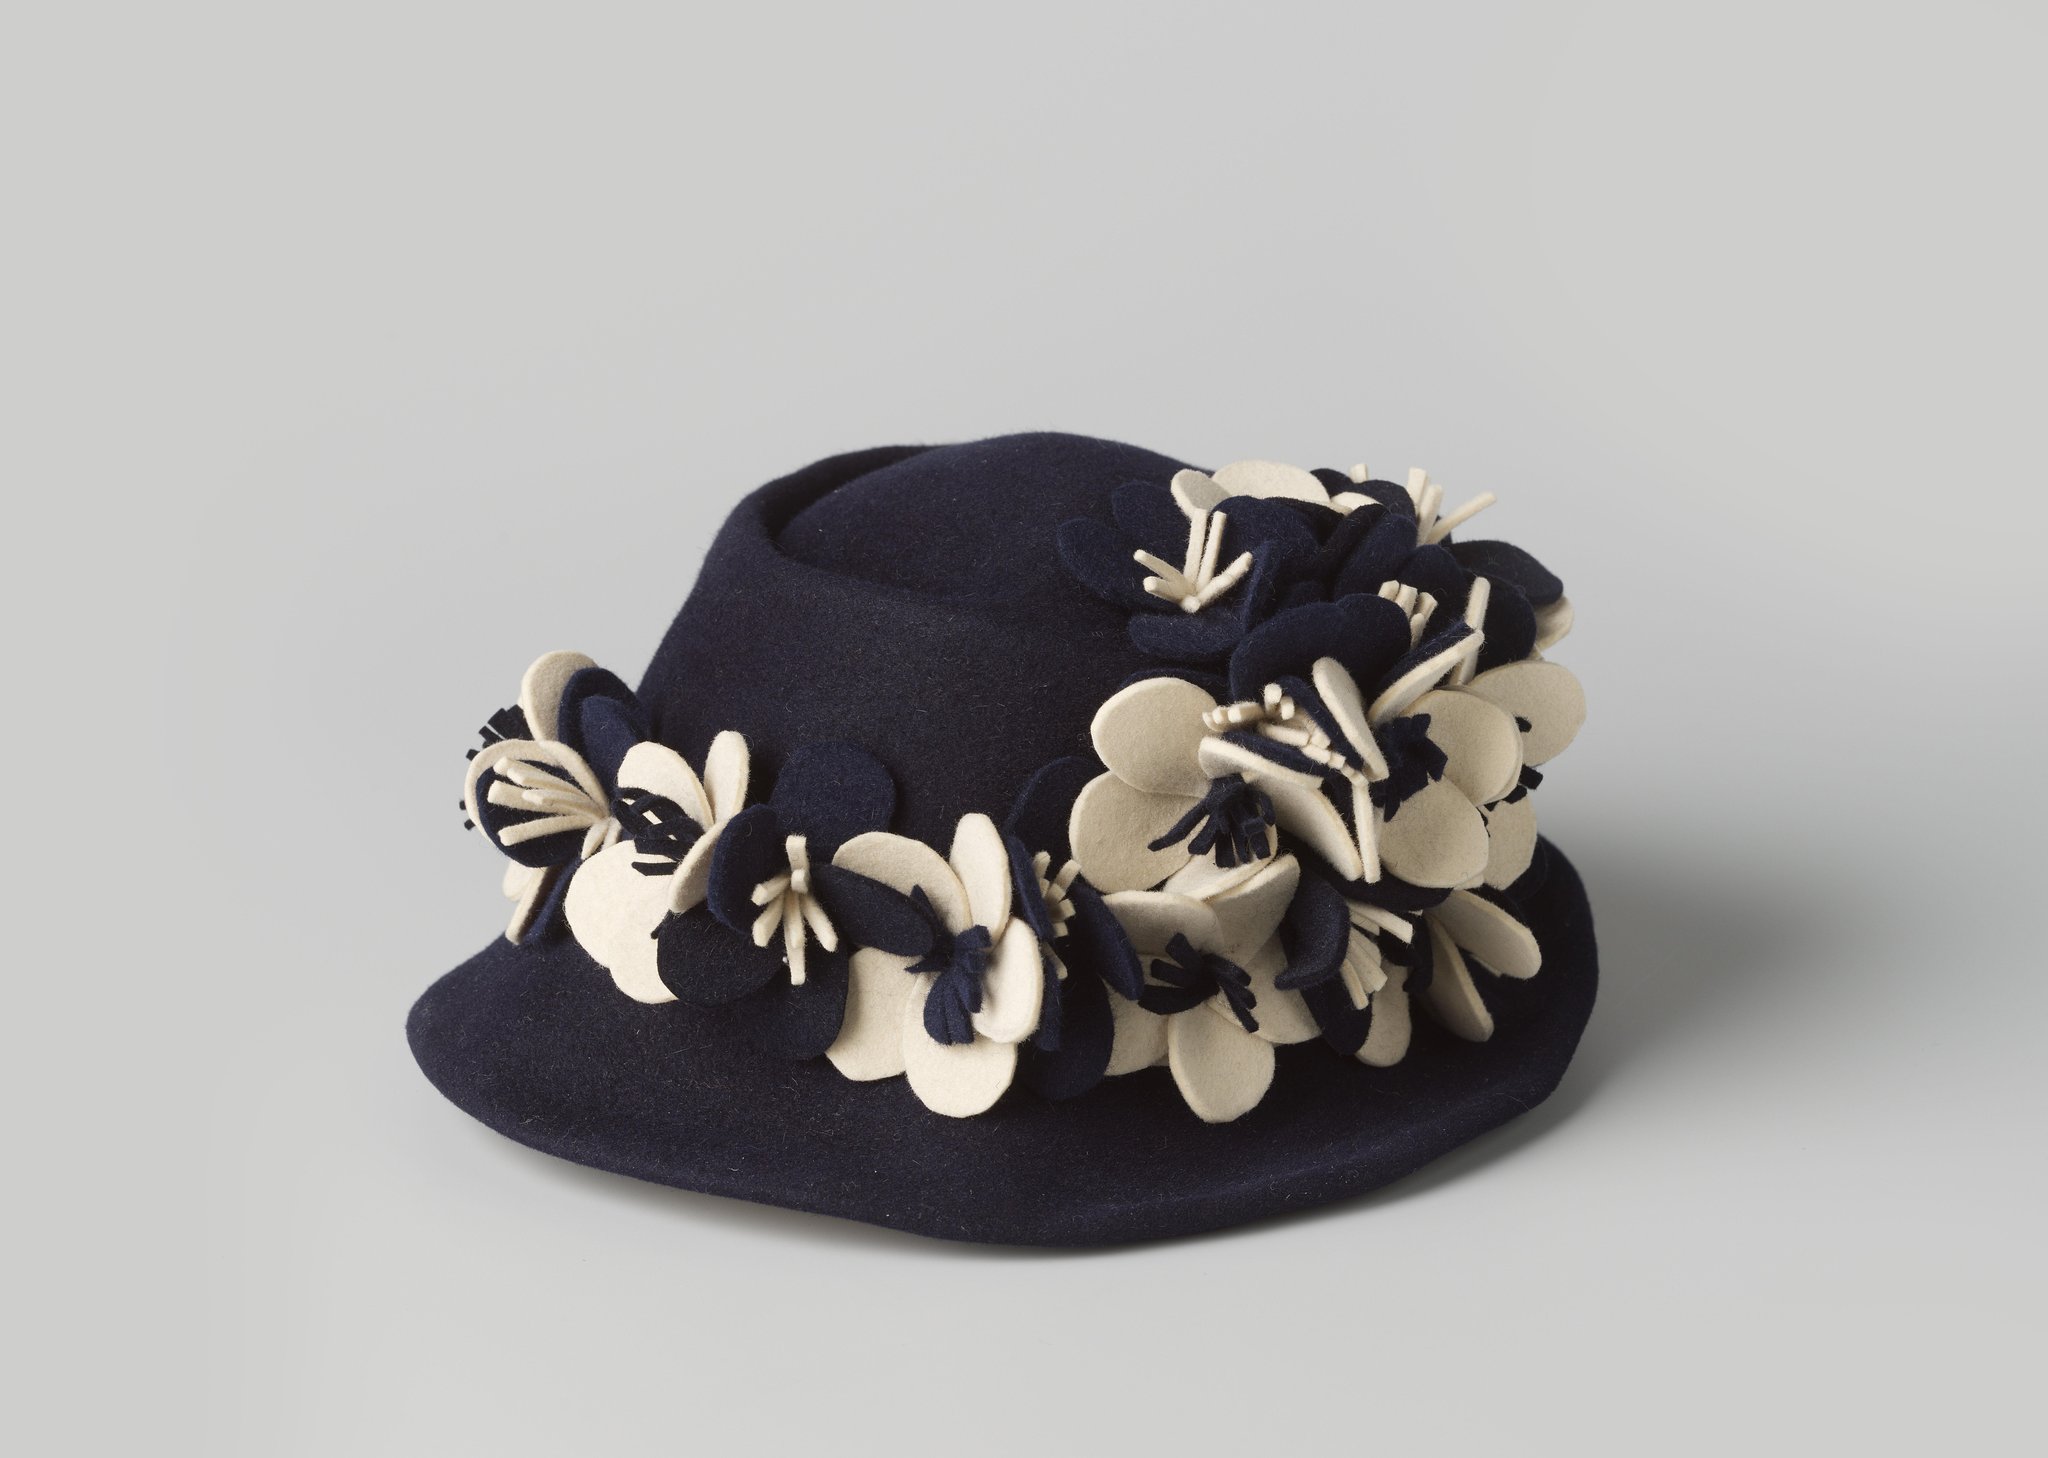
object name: hat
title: Hoed van blauw vilt met bloemen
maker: Anonymous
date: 1955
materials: felt, metal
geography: amsterdam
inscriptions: mark: ‘De Prijslijst / AMSTERDAM / 53 P.C. HOOFTSTRAAT’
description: Hoed van blauw vilt met bloemen. Ronde bol met een ringdeuk en kleine met laiton verstevigde rand, opzij geslagen, vanachter aflopend. Met hoedenelastiekje. Aan de voorzijde tegen de bol een toef bloemen, in een slinger uitlopend. Rondom een smal lint van wit vilt. De binnenrand is belegd met wit vilt.